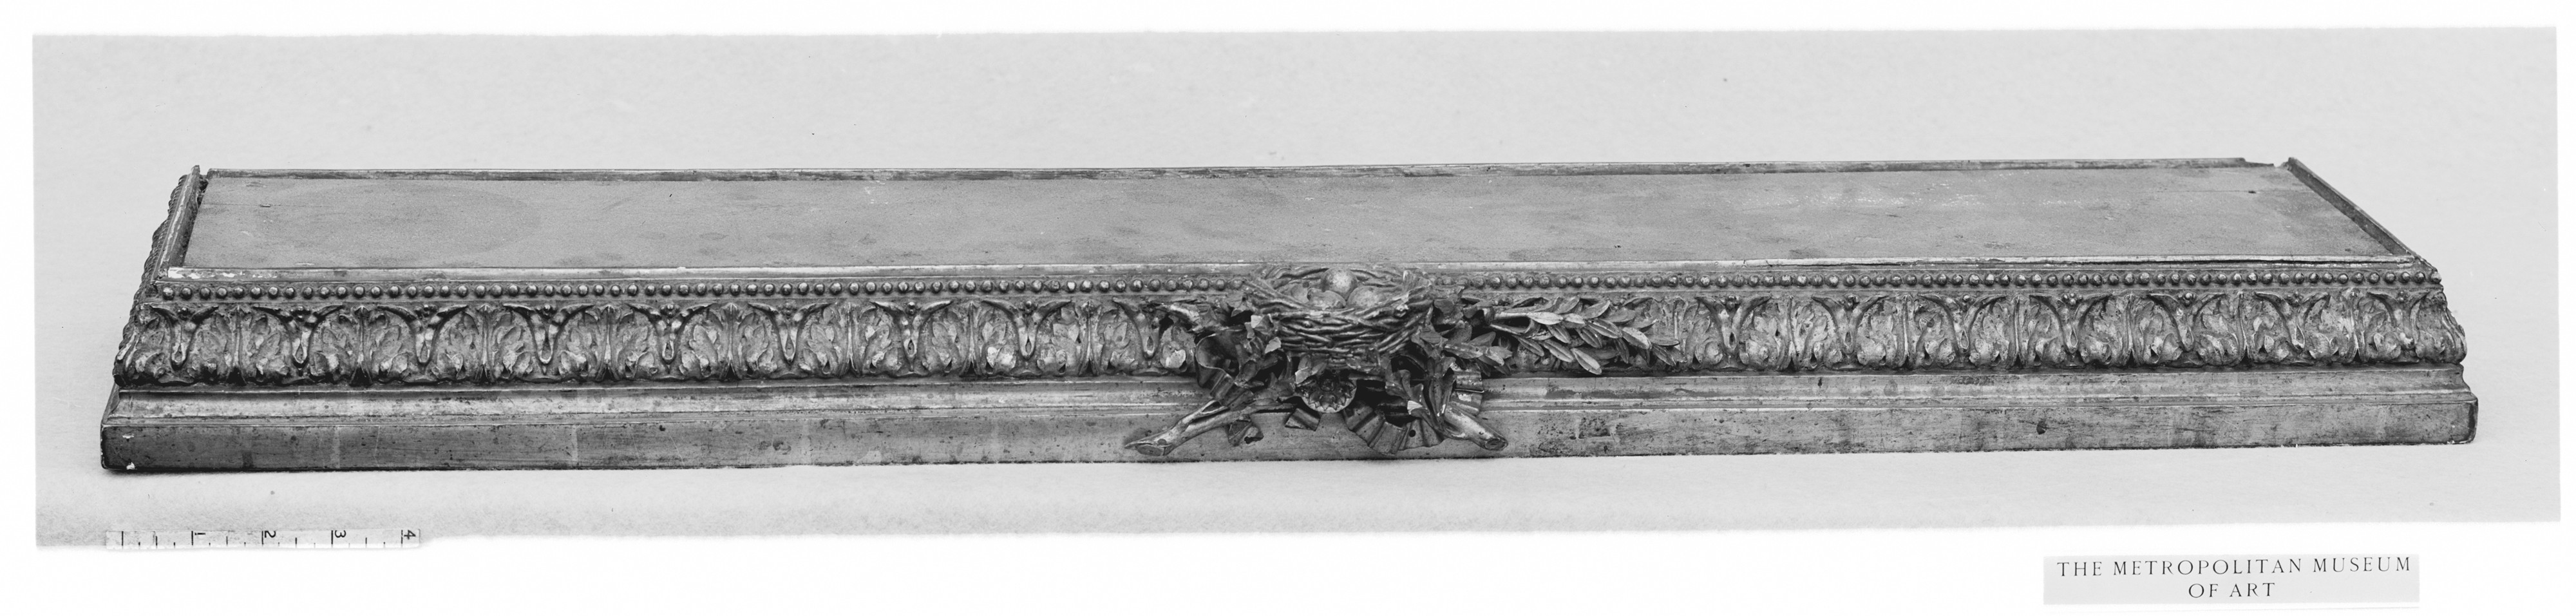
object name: plinth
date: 1701-1800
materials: gilt, wood